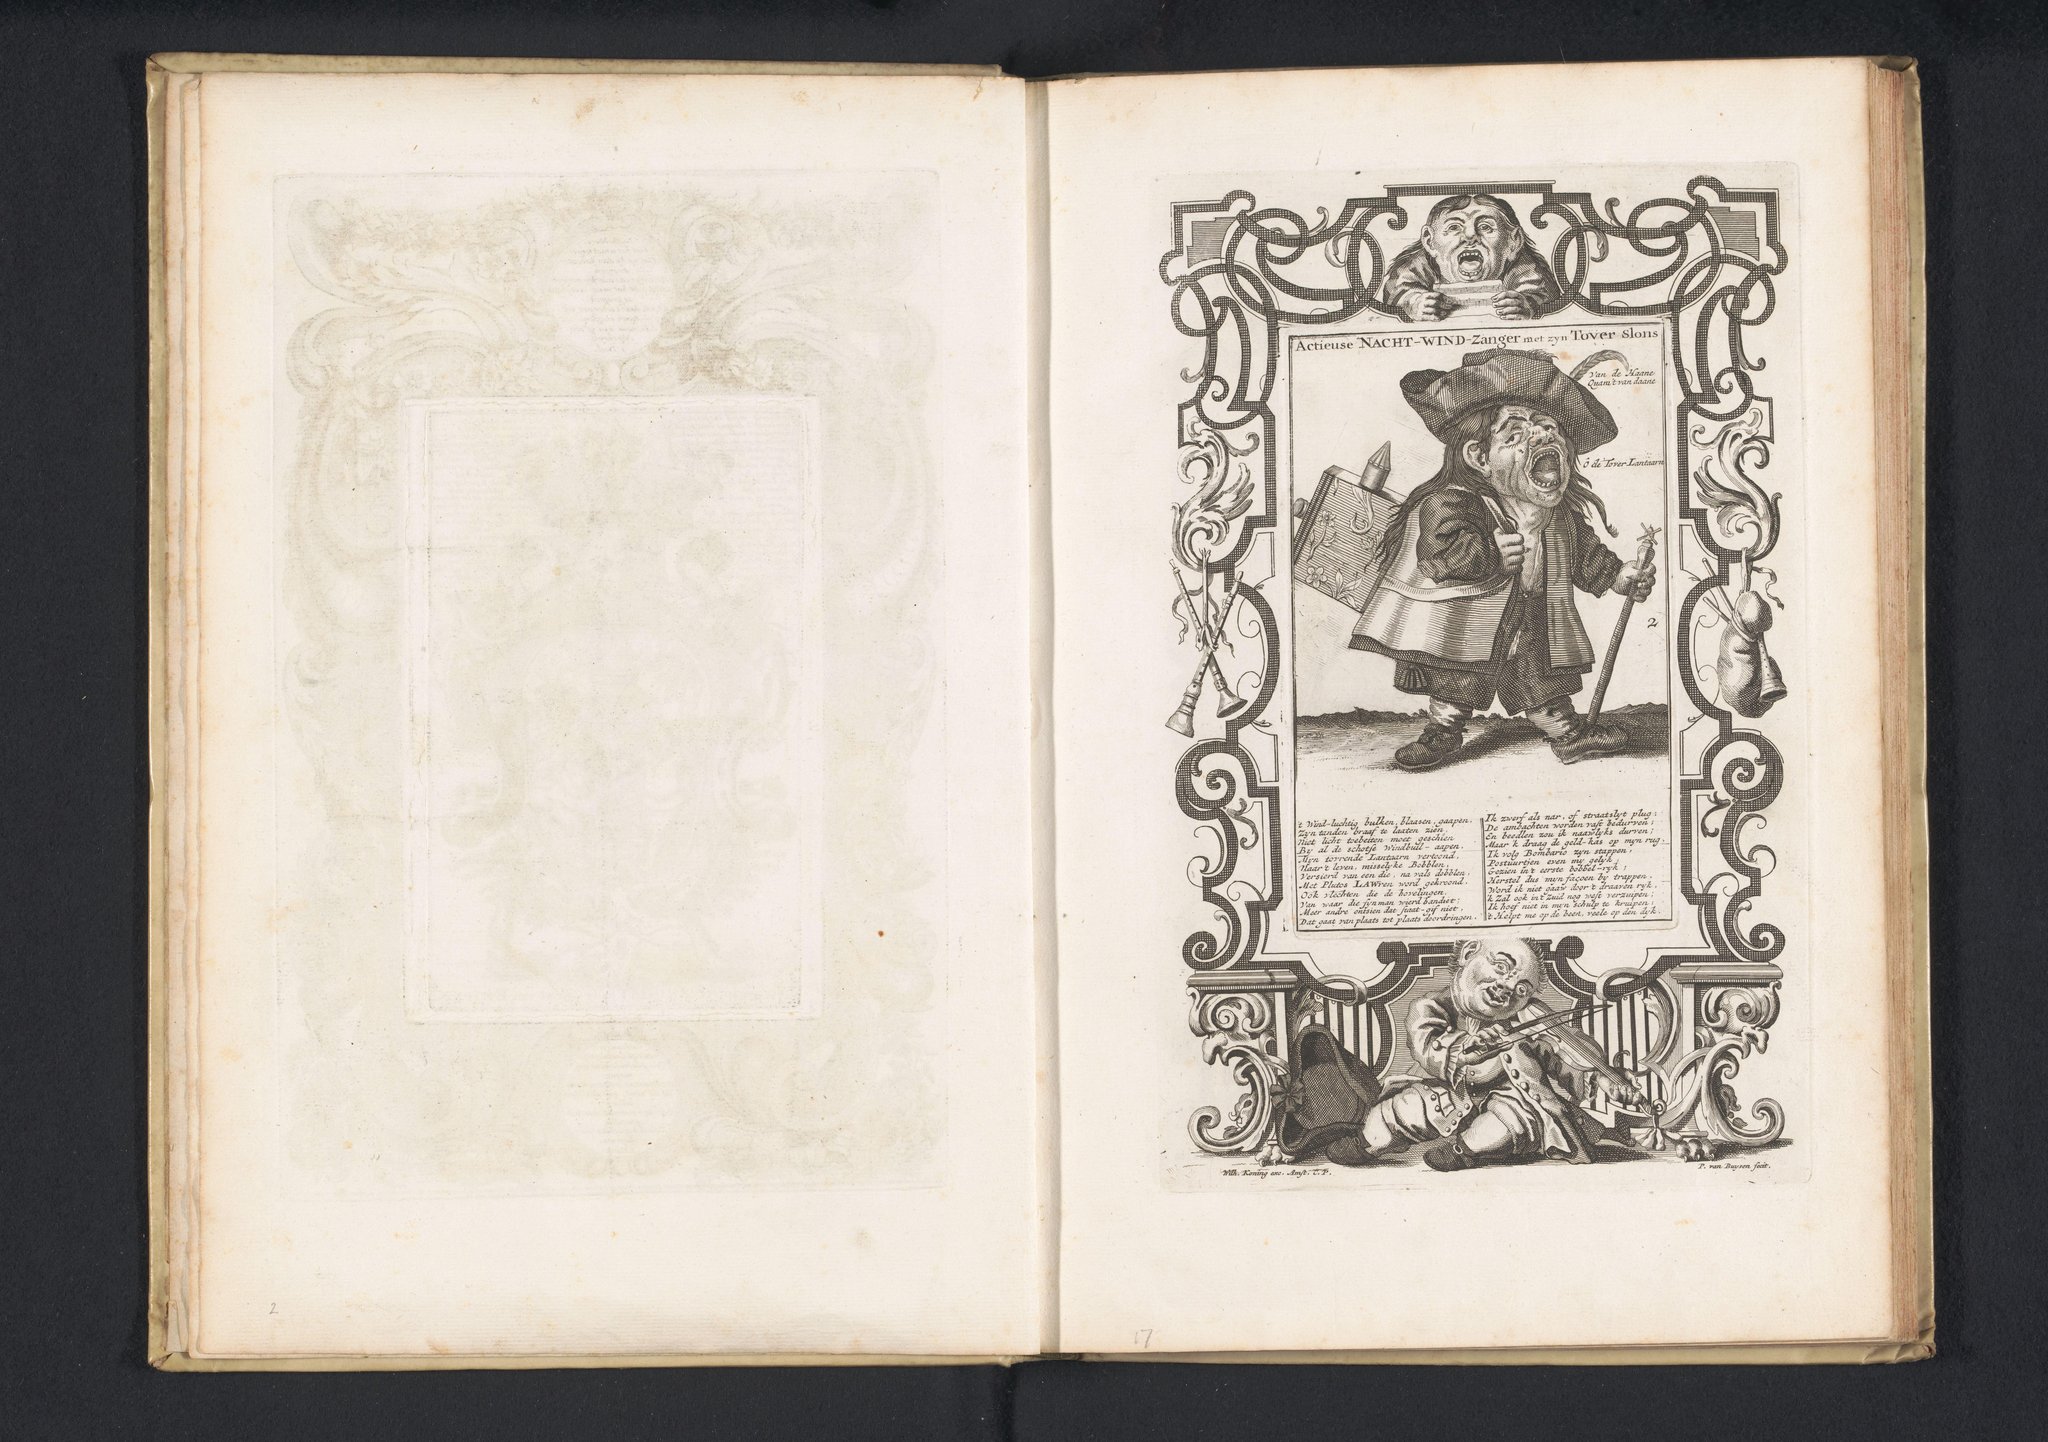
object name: print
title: Bombario Actionist en de Geest van Esopus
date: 1716-1720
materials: paper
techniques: etching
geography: northern netherlands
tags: caricatures (human types), little people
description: Een kleine mens als nachtwaker met een toverlantaarn op zijn rug. Afdruk binnen een decoratieve omlijsting gedrukt van een aparte plaat met een zingende en een vioolspelende kleine mens. In het onderschrift een vers in twee kolommen in het Nederlands. Genummerd rechts midden: 2. Onderdeel van de tweede Nederlandse gebonden uitgave uit 1720 (en gerelateerd aan de Windhandel in dat jaar) van een serie karikaturen van kleine mensen, bekend als Het Dwergentooneel, deels gekopieerd naar een ouder Duits voorbeeld.